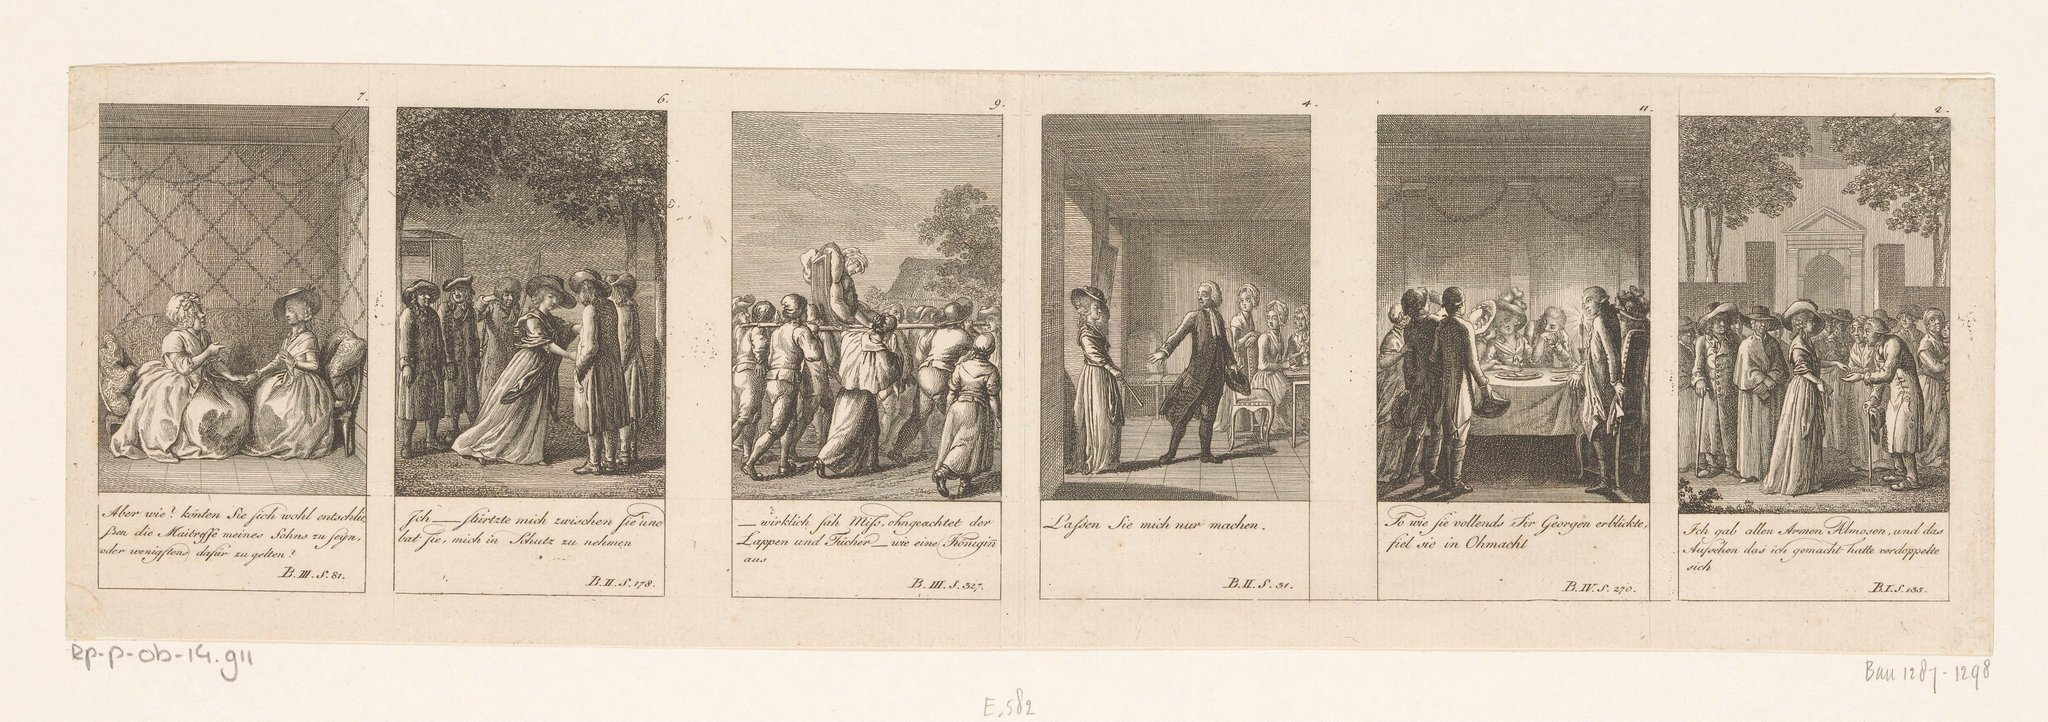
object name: print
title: Zes voorstellingen uit Camille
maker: daniel nikolaus chodowiecki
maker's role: draughtsman, print maker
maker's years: 1726-1801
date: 1787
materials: paper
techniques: etching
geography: berlin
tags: vienna, help (to an endangered fellow man), city-view, and landscape with man-made constructions, (carrying a person on a) litter, stretcher, literature, interior of the house, evening meal, dinner, supper, meeting, giving alms; collection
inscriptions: collector's mark: Lugt 2228